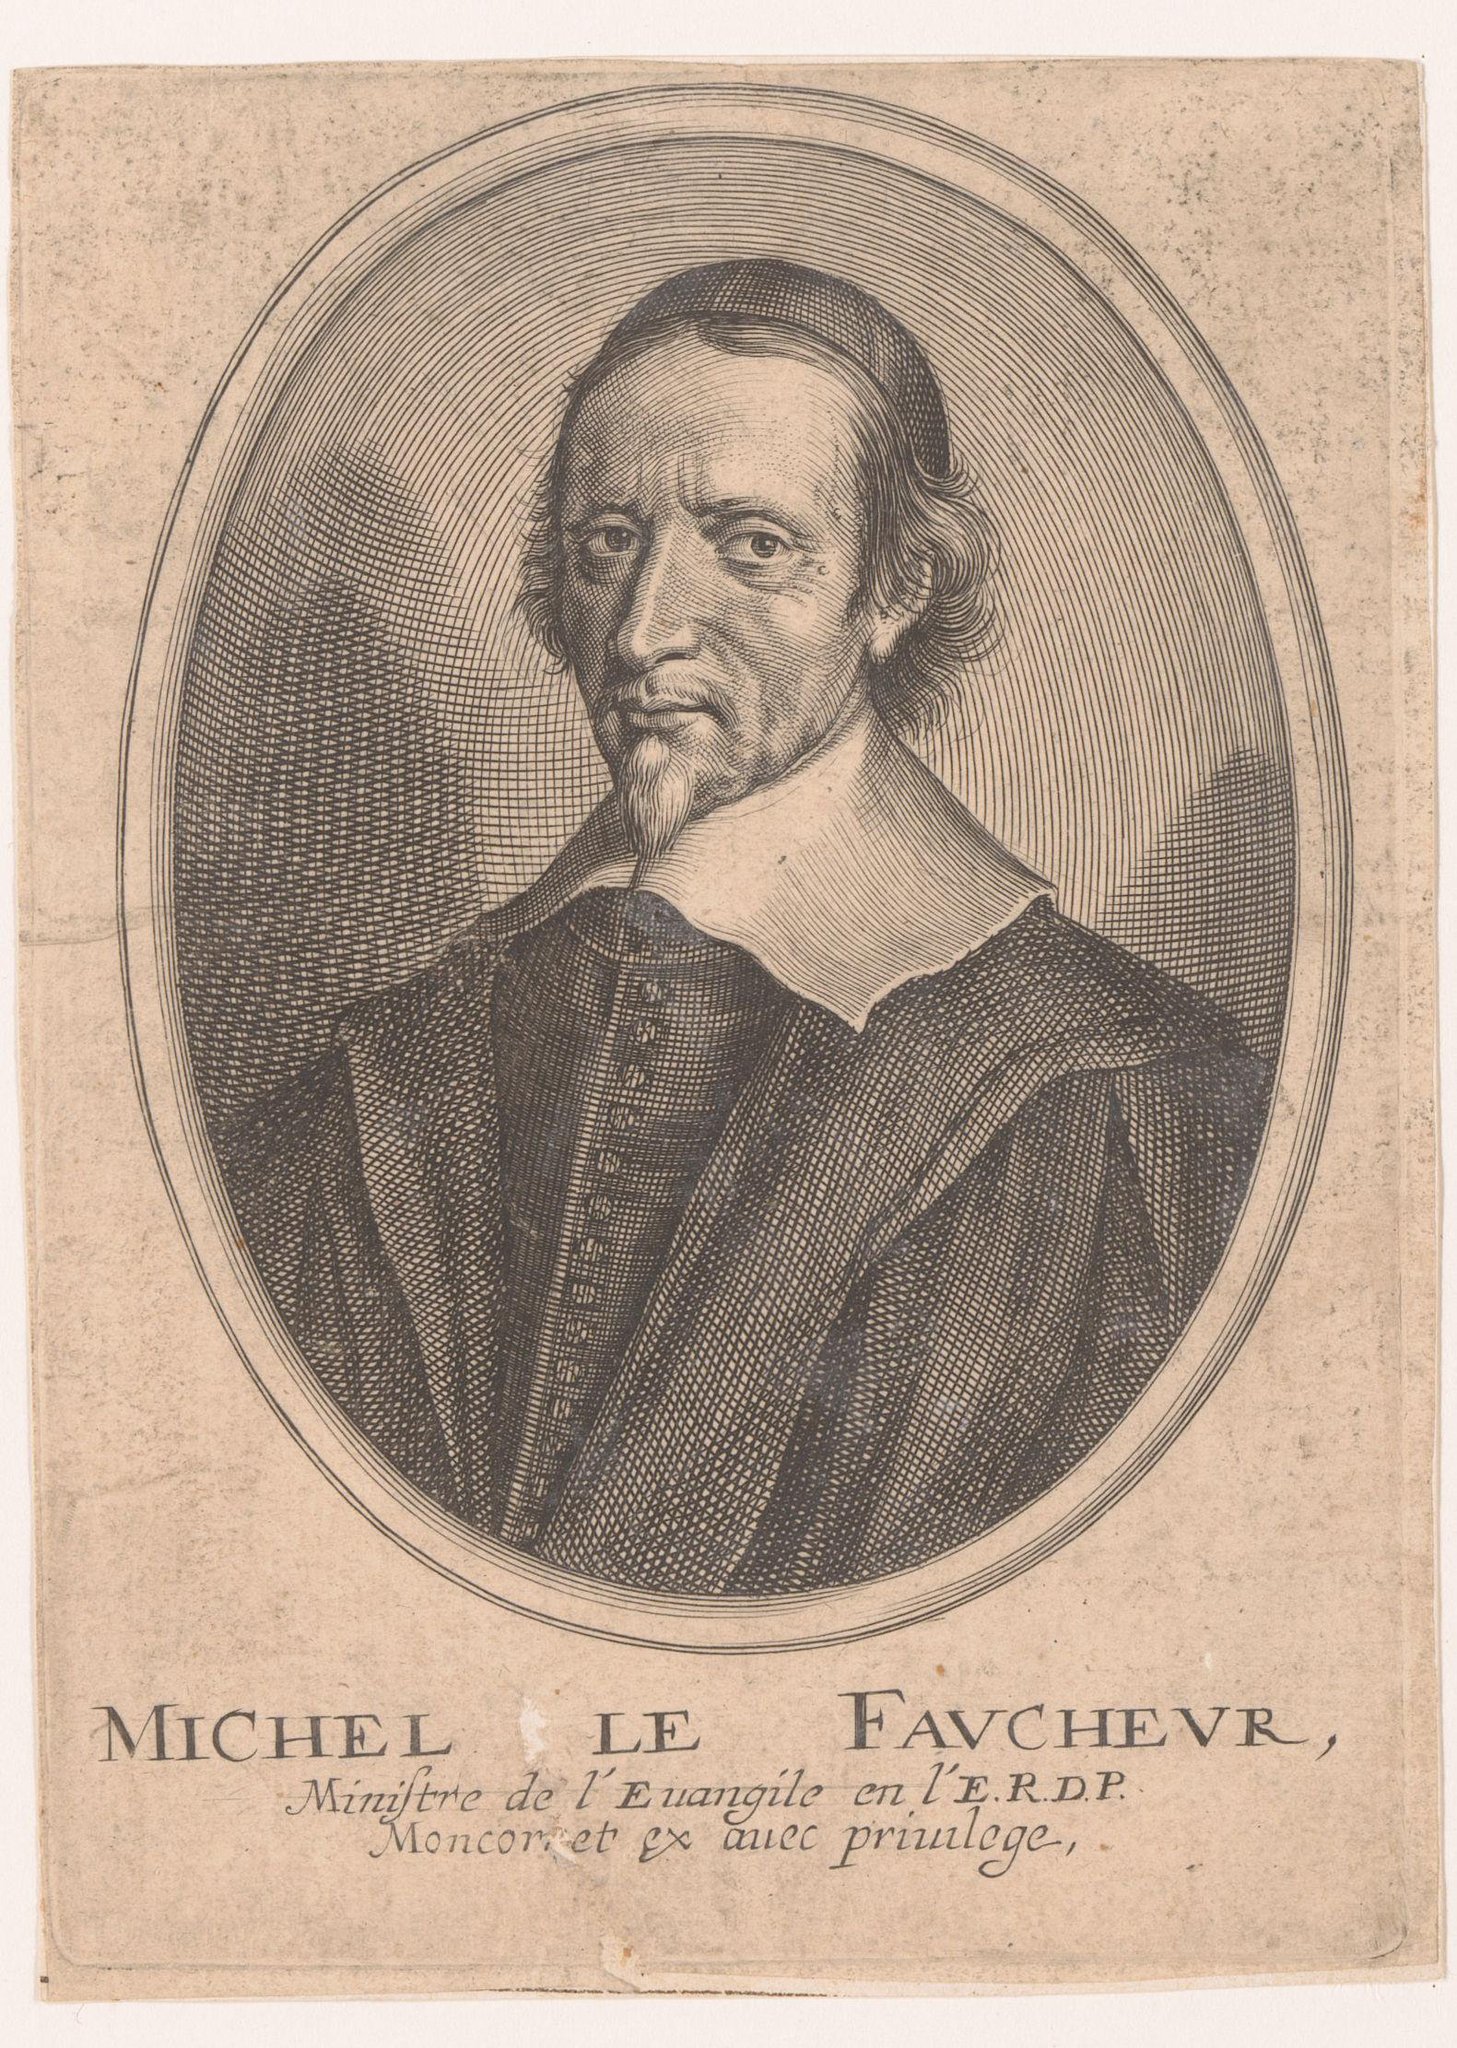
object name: print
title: Portret van Michel le Faucheur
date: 1635-1668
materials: paper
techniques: engraving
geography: paris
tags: priest (roman catholic), historical persons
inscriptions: collector's mark: Lugt 2228